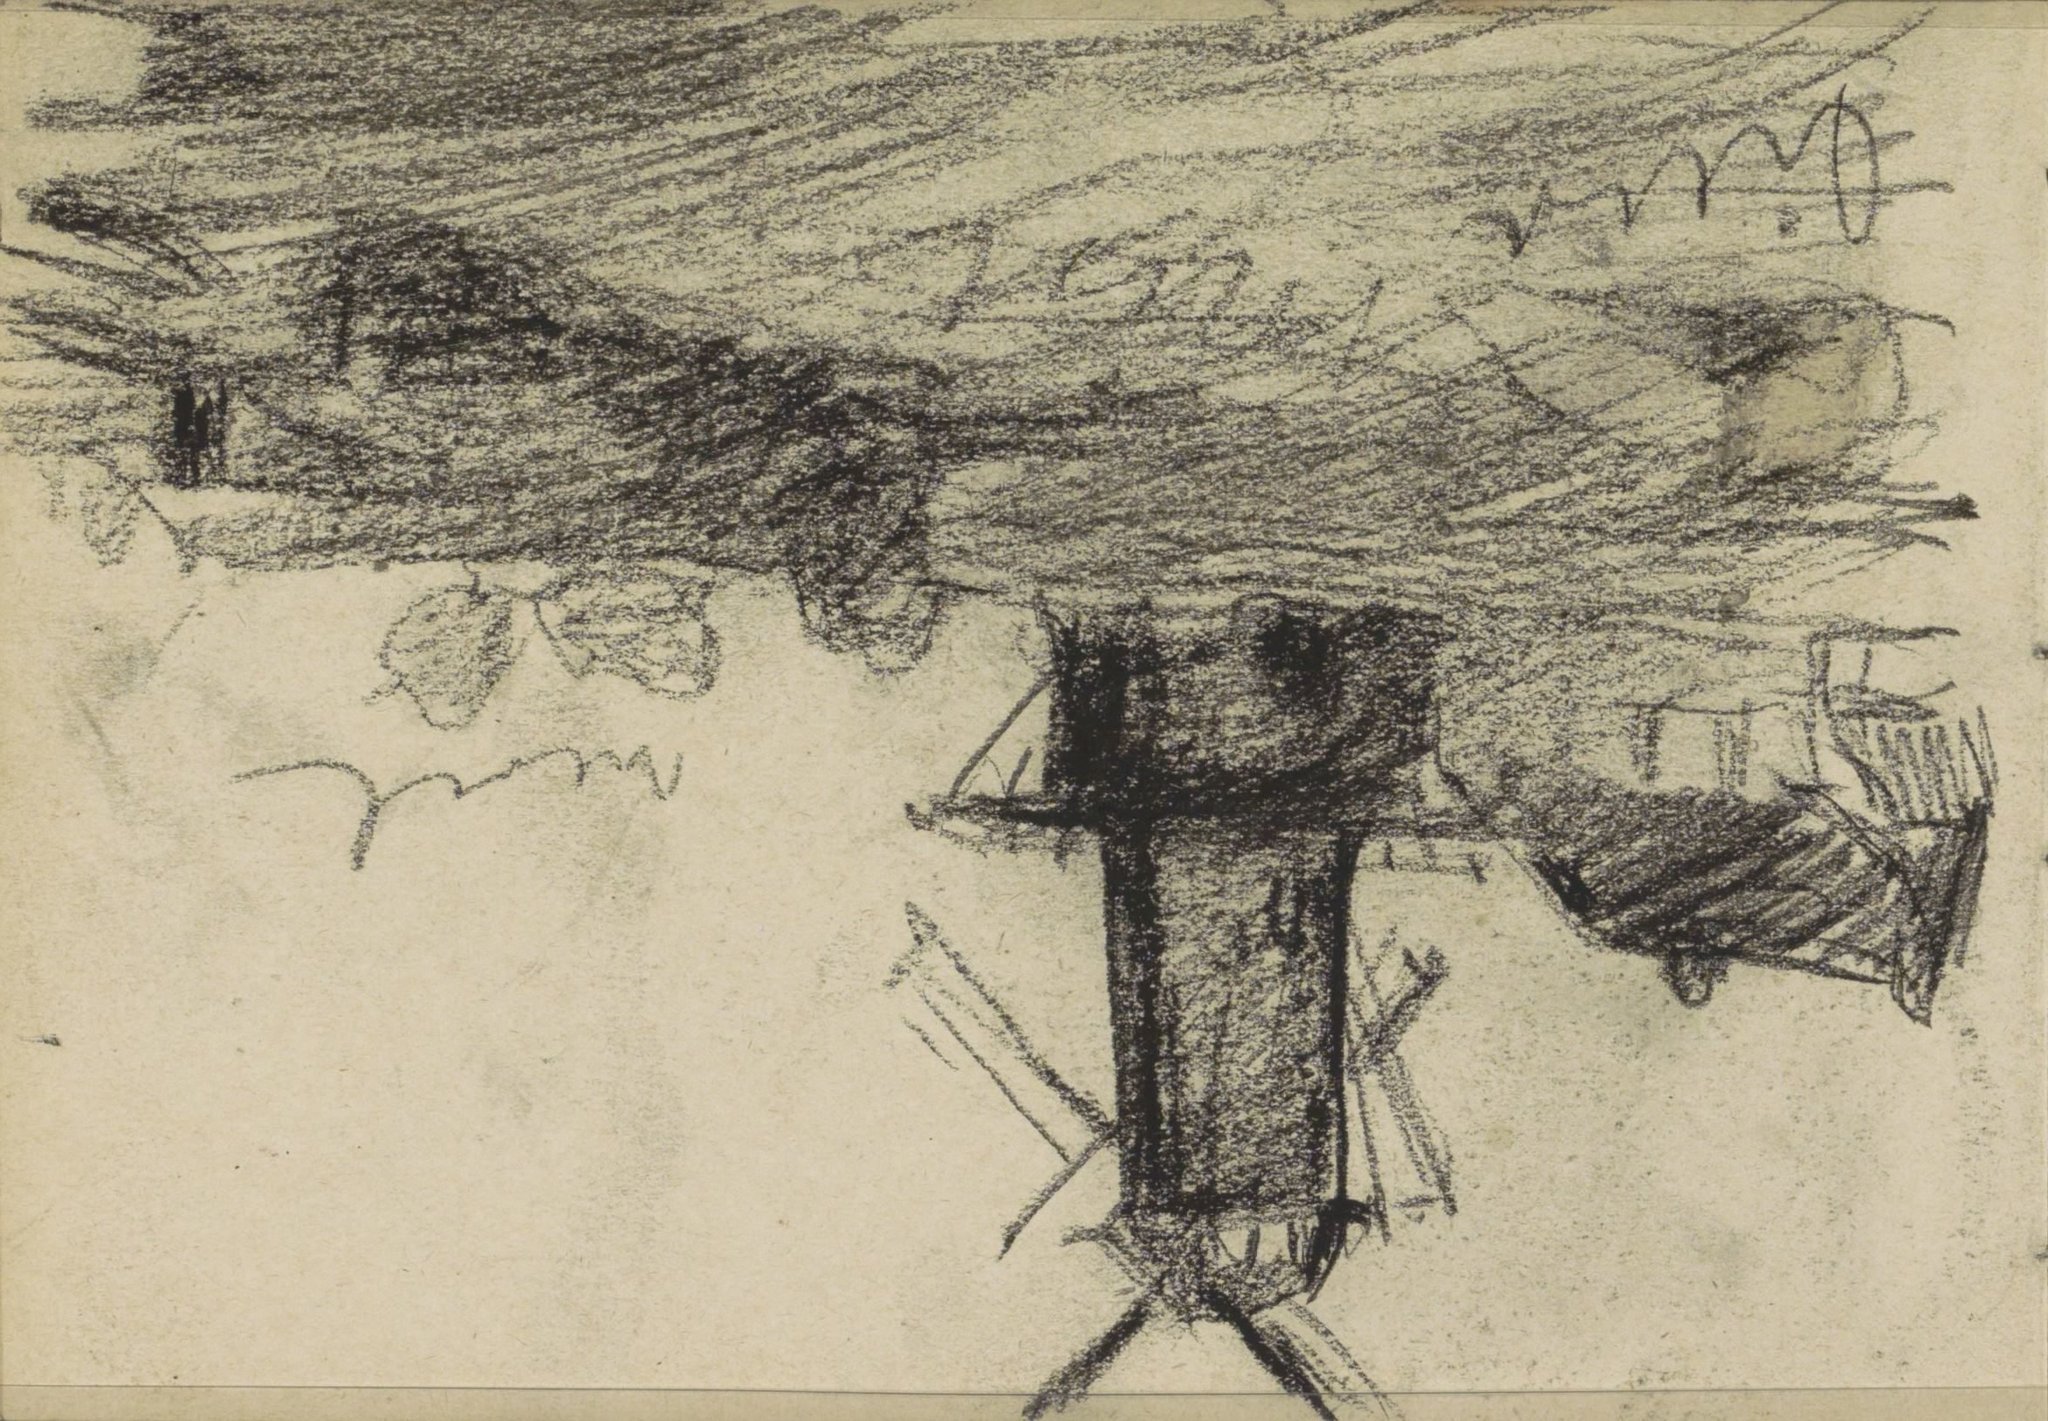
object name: sketchbook leaf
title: Gezicht op de molen Rijn en Lek te Wijk bij Duurstede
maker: willem witsen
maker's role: draughtsman, painter, print maker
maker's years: 1860-1923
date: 1906-1907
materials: chalk, paper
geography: wijk bij duurstede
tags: windmill in landscape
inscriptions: kleurnotitie, handgeschreven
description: Voorstudie voor de ets 'Molen aan het water, Wijk bij Duurstede, de rivier links', ca. 1906.